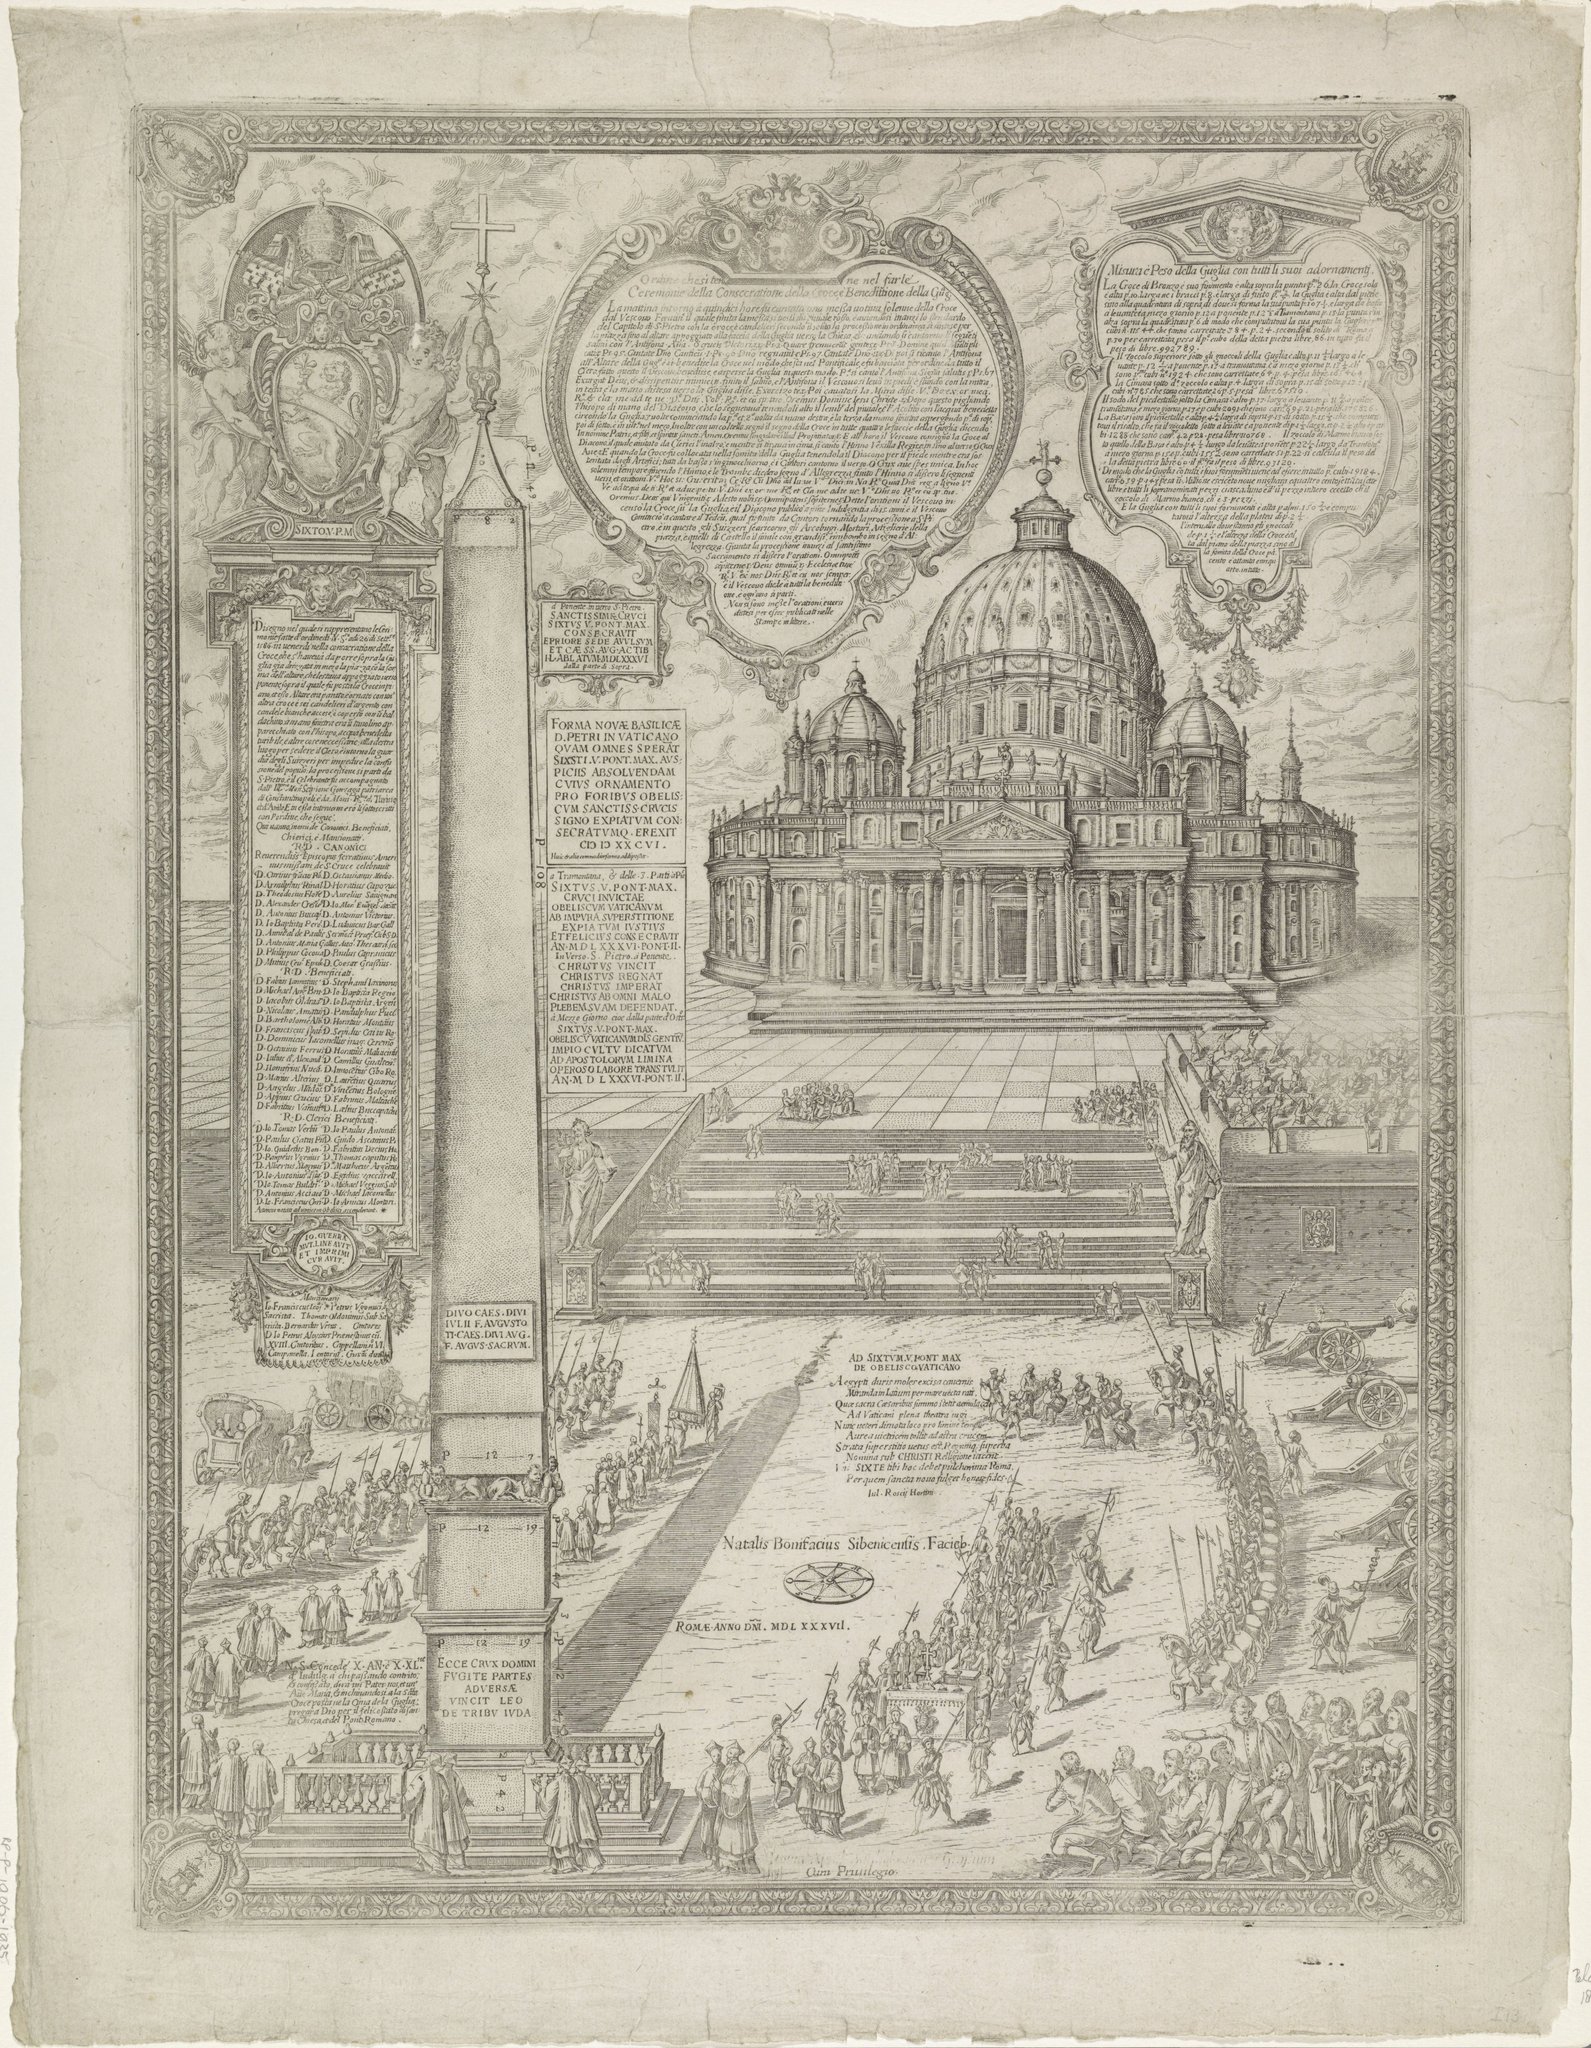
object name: print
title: Wijding van het kruis op de Vaticaanse Obelisk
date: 1587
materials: paper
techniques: etching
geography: rome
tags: rome, sixtus v, obelisk, needle, roman catholic church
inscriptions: collector's mark: Lugt 2228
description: Zicht op het Sint-Pietersplein, met de Vaticaanse Obelisk en de Sint-Pietersbasiliek. Op het plein vindt een religieuze ceremonie plaats: de wijding van het kruis dat tijdens het pontificaat van paus Sixtus V op de top van de Vaticaanse Obelisk is geplaatst. Boven zes cartouches met tekst in het Italiaans. De voorstelling is gevat in een sierlijst.